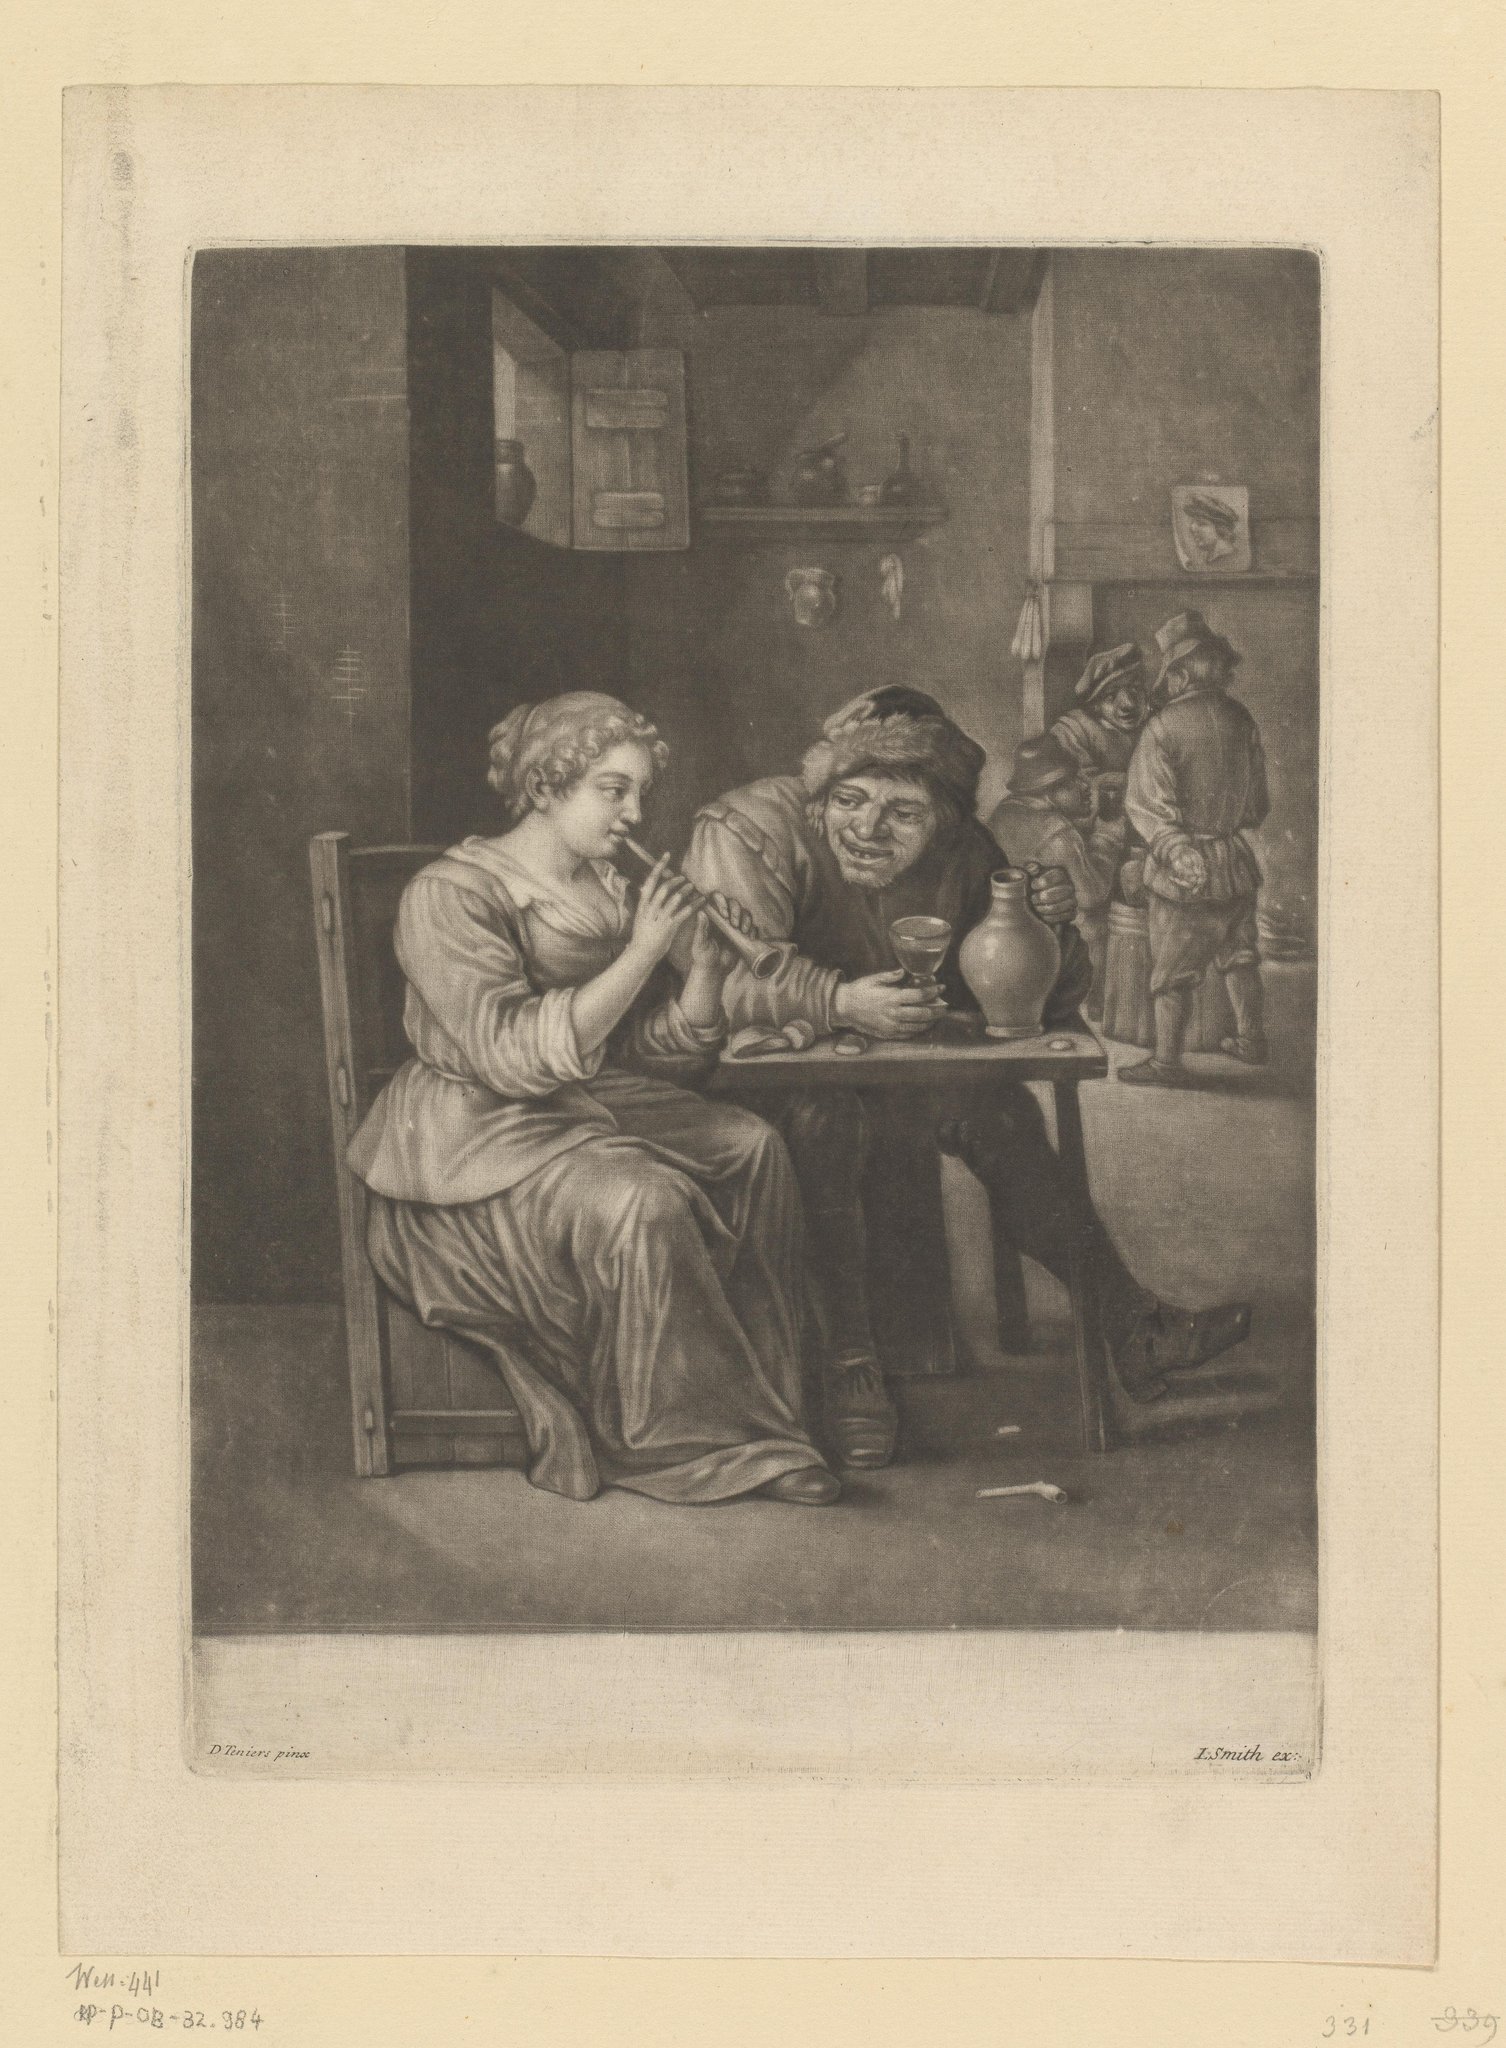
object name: print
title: Fluitspeler in een herberg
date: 1662-1742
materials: paper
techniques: mezzotint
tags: adolescent, young woman, maiden, musician, hotel, hostelry, inn, flute, aulos, tibia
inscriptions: collector's mark: Lugt 240